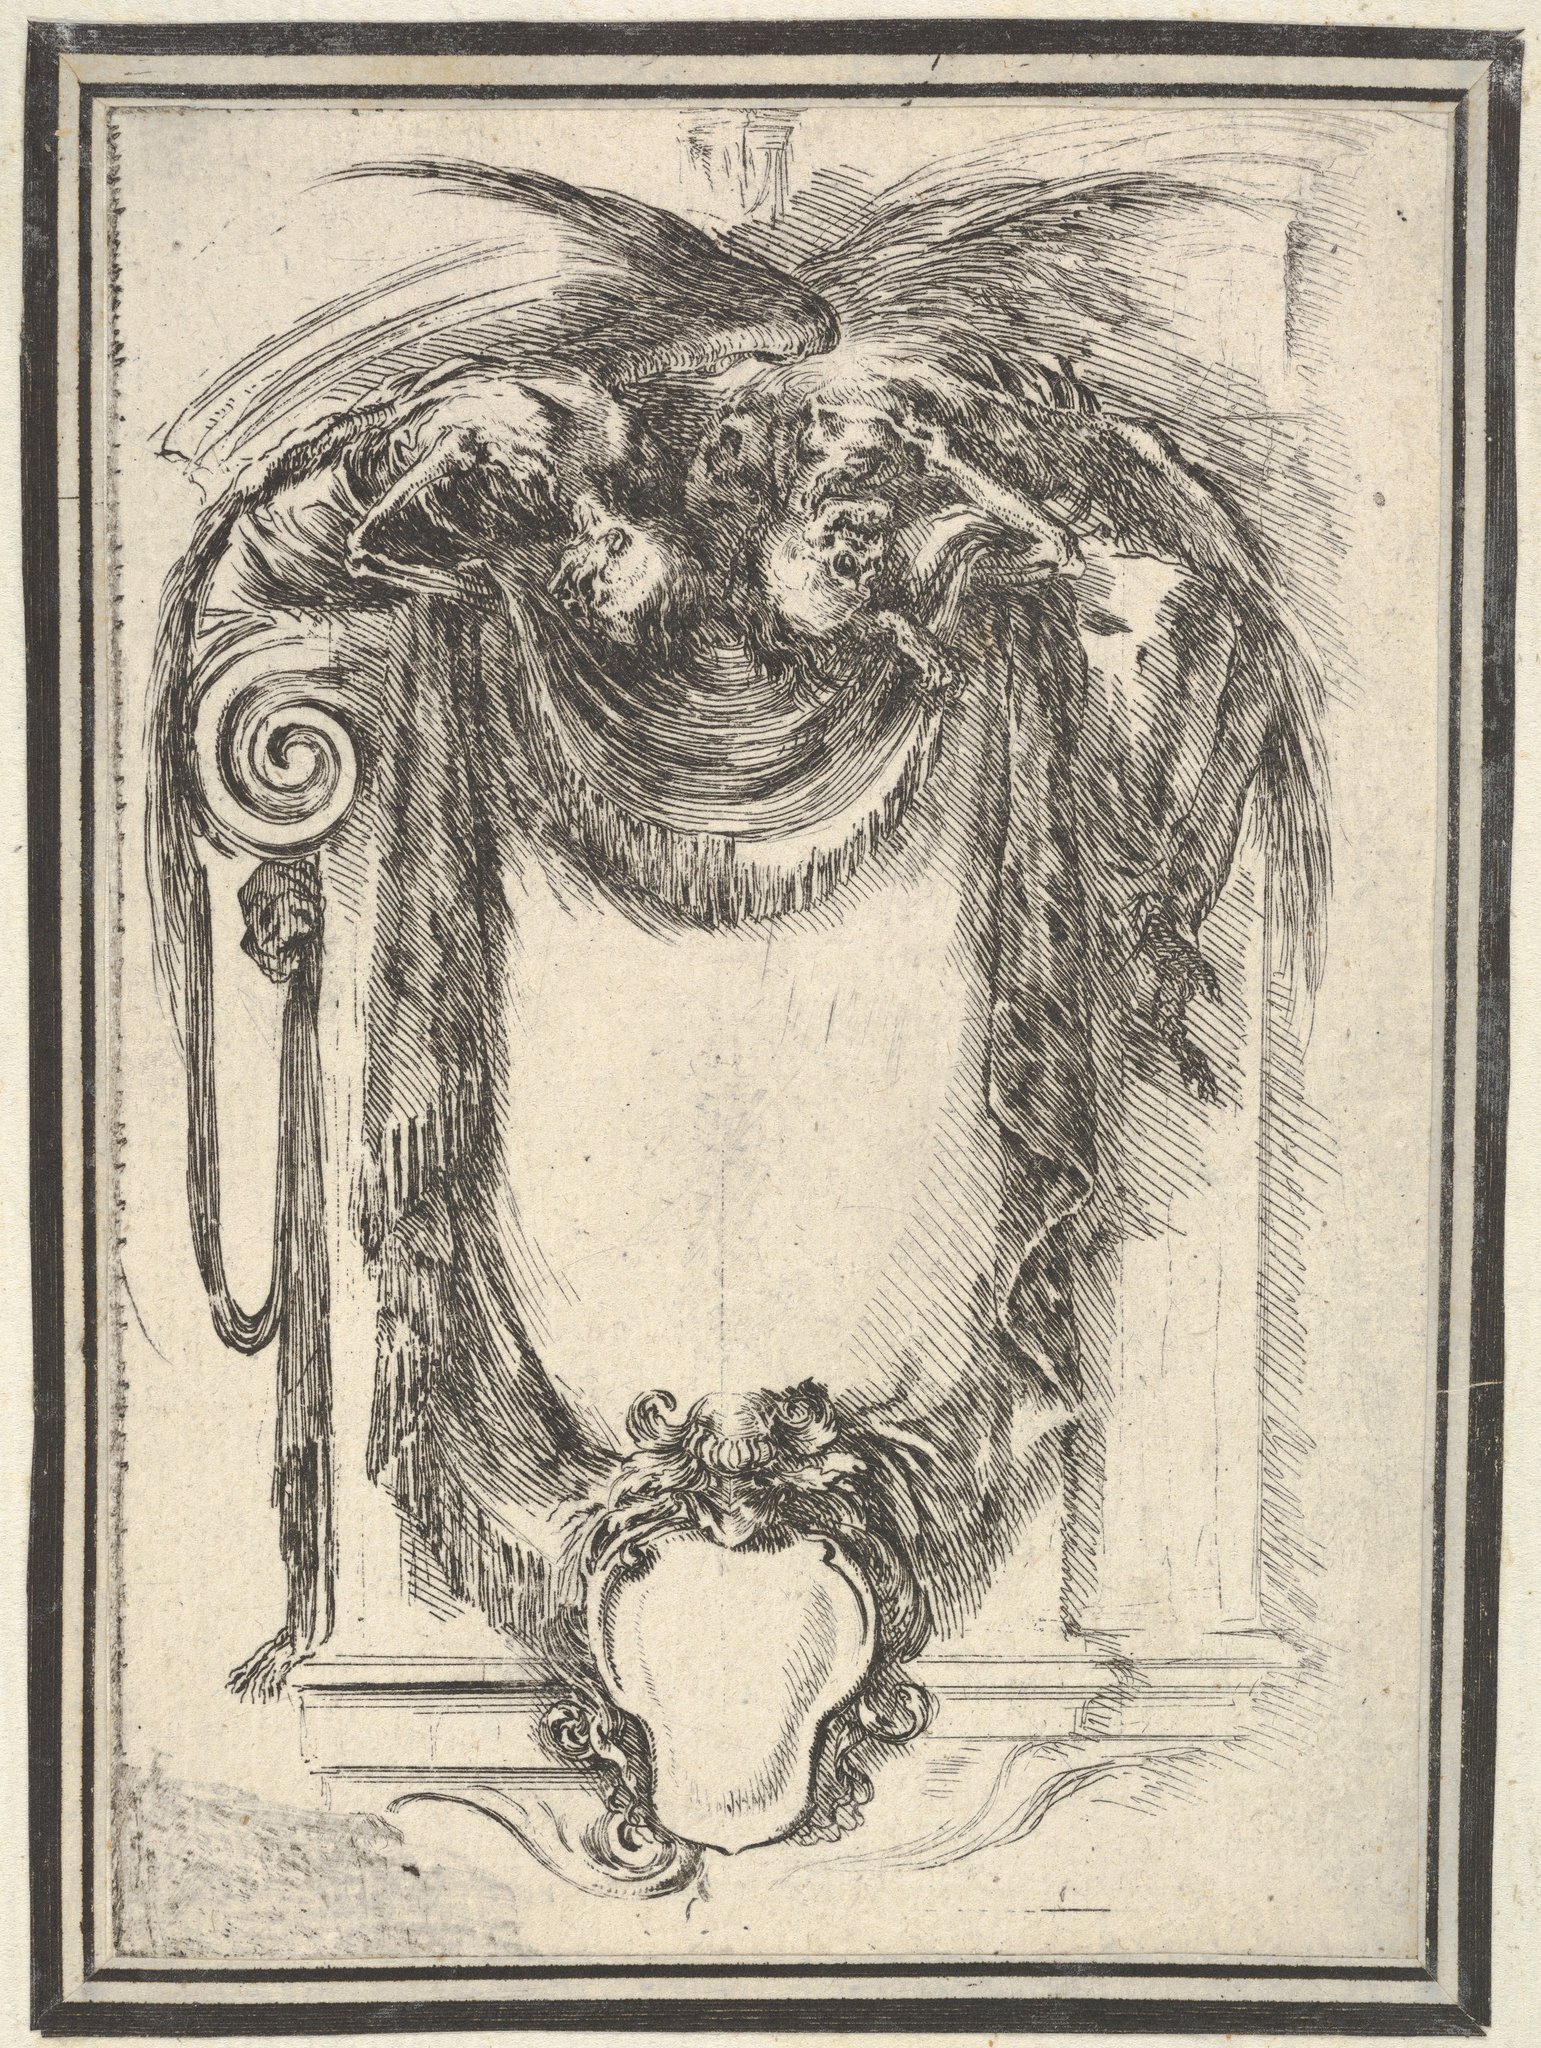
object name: print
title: A cartouche formed by drapery and topped with two skeletons atop an Ionic entablature, plate 10 from "Nouvelles inventions de Cartouches"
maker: stefano della bella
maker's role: artist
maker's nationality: italian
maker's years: 1610-1664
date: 1647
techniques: etching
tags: cartouches,skeletons